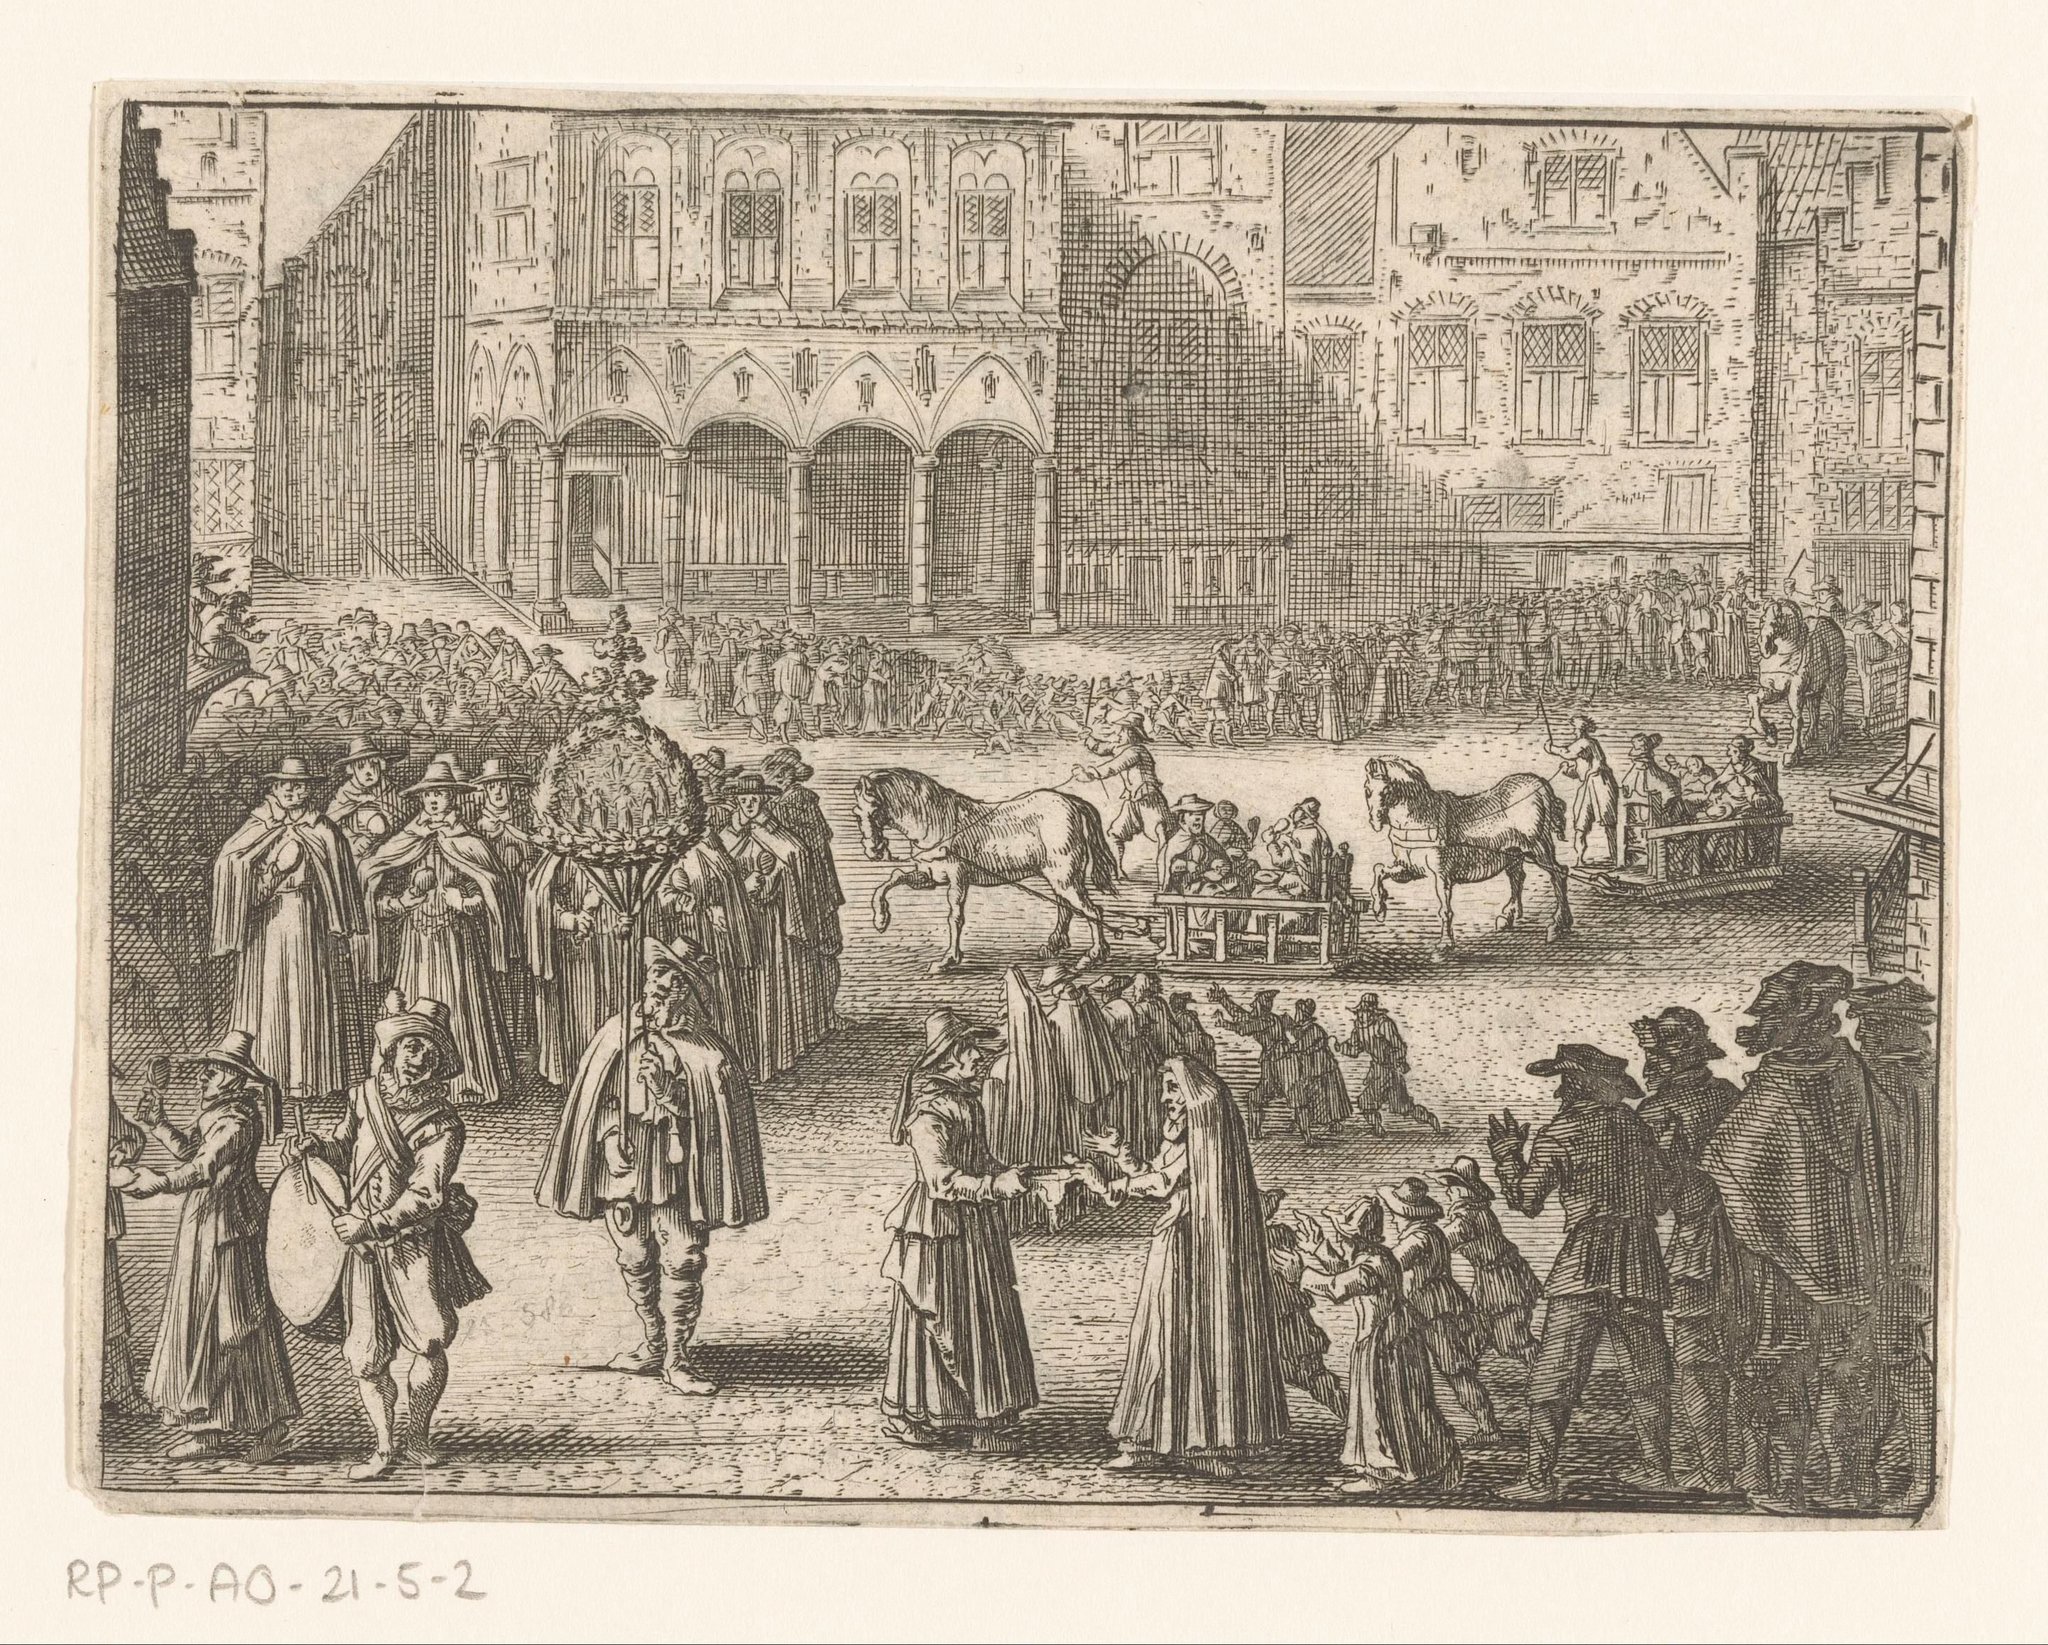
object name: print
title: Leprozenoptocht op Koppermaandag te Amsterdam, 1604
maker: Anonymous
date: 1693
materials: paper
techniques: engraving, etching, letterpress printing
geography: amsterdam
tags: 'blue monday', leper's procession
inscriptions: collector's mark: Lugt 2228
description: De jaarlijkse optocht van de gilden op Koppermaandag (de eerste maandag na Driekoningen) te Amsterdam, 1604. Optocht en feestelijkheden van de gilden op de Dam waarbij de leprozen de stad in mogen en waarbij geld voor hen werd ingezameld. In 1604 werd Koppermaandag voor het laatst in Amsterdam gevierd. Op verso Nederlandse tekst.